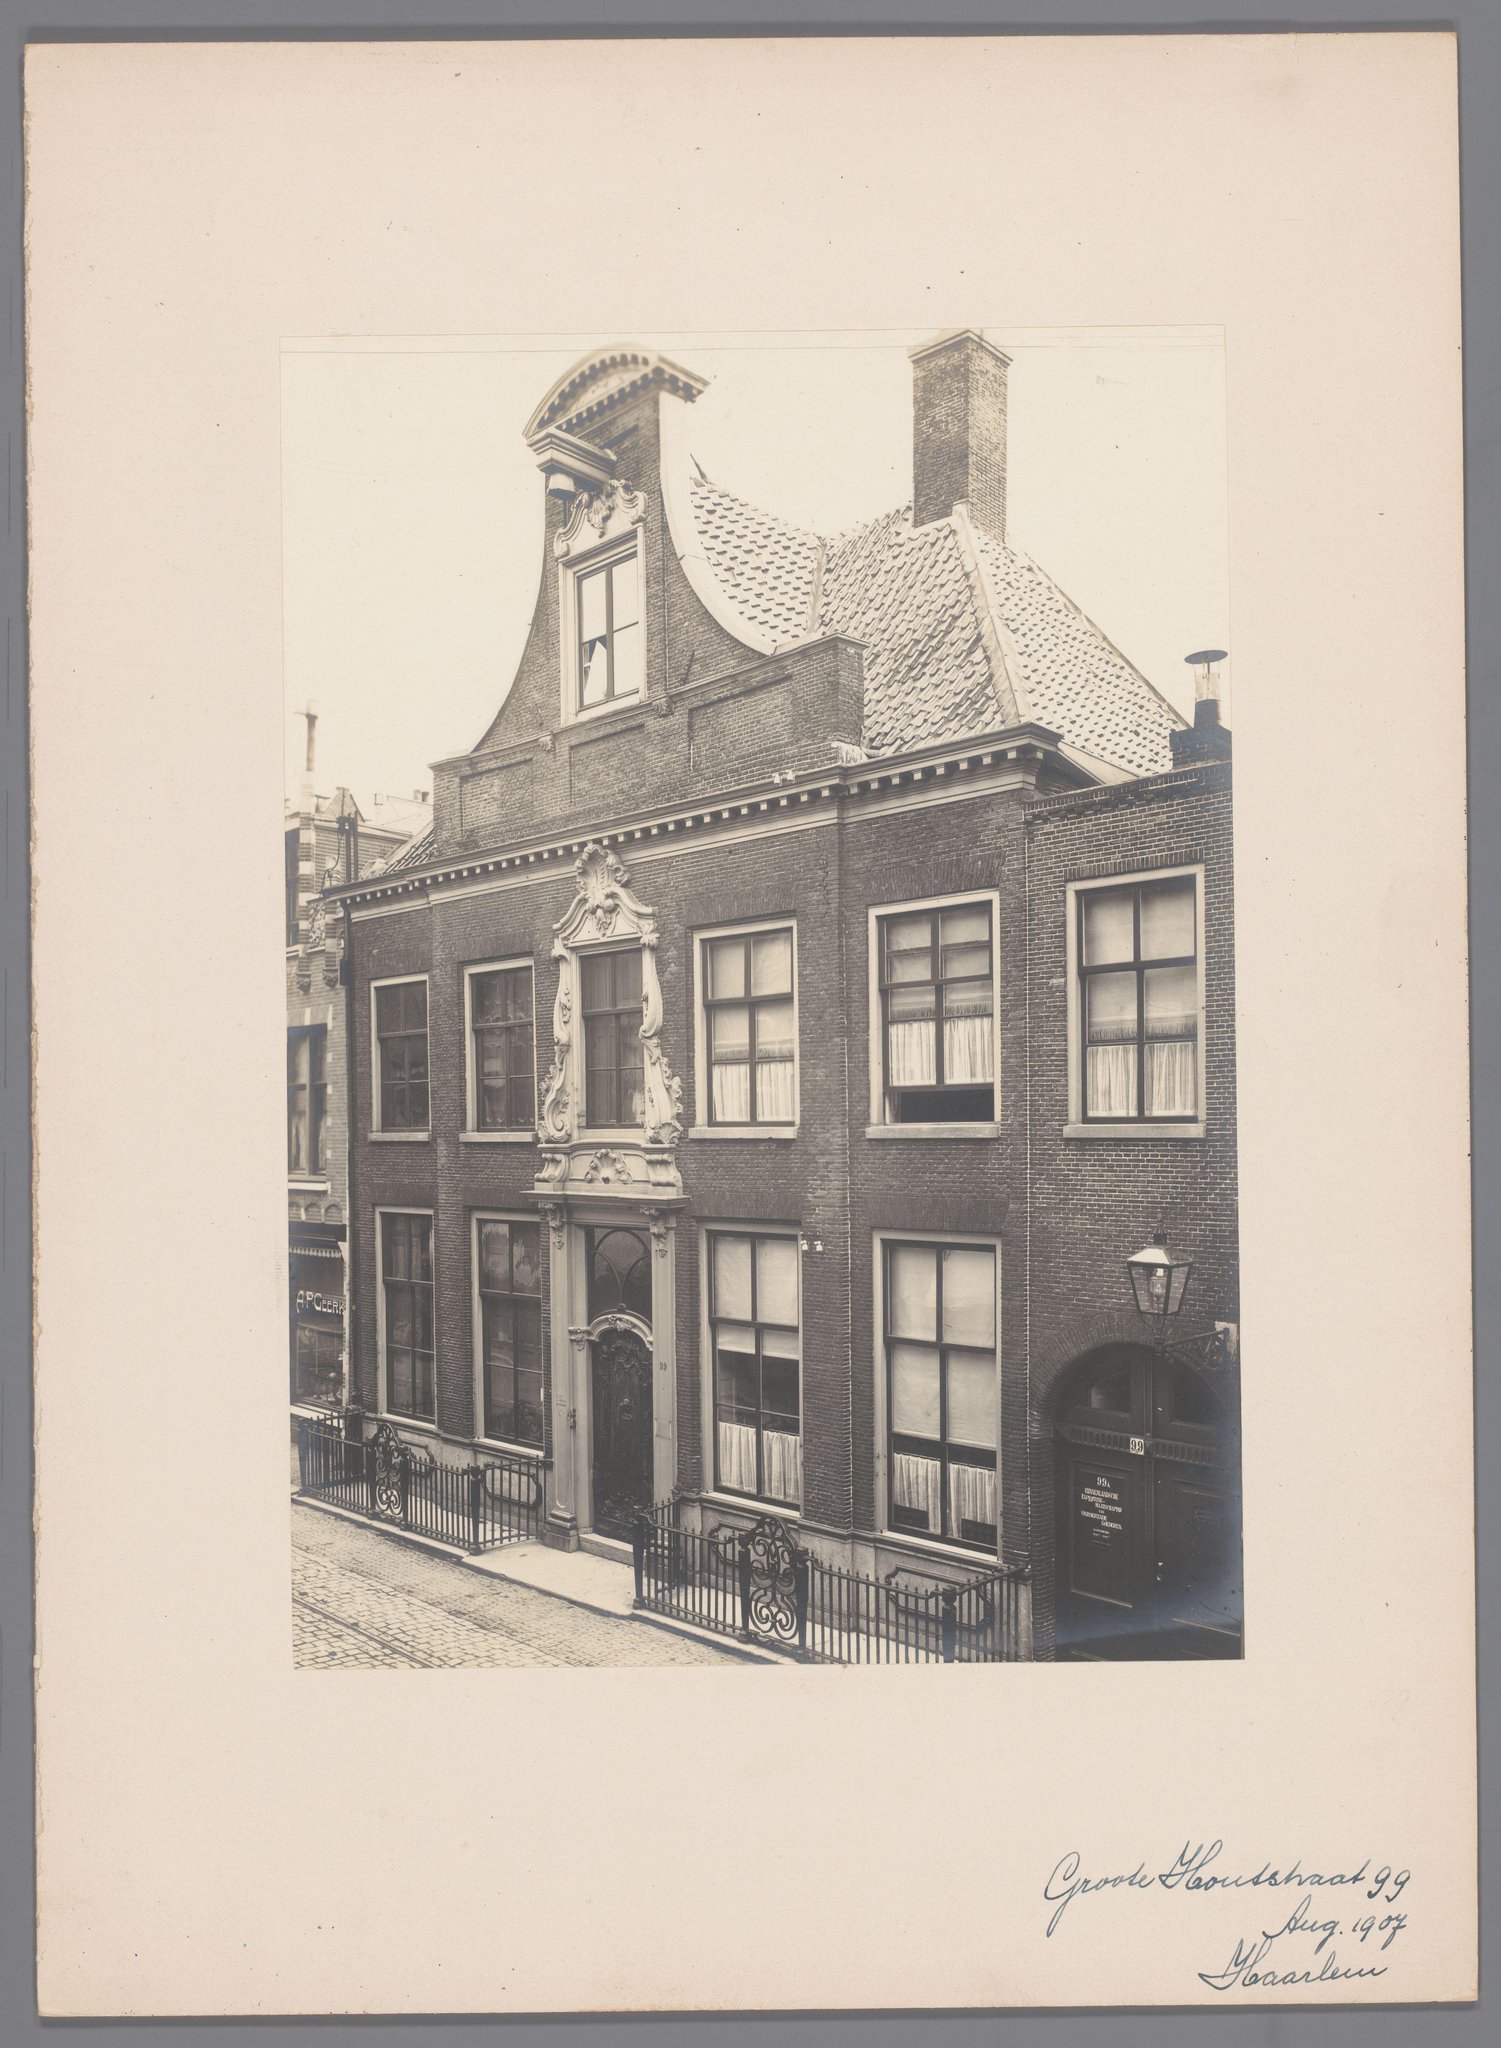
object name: photograph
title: Façade van Grote Houtstraat 99 te Haarlem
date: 1907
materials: cardboard, photographic support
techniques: gelatin silver print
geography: grote houtstraat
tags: urban housing, façade (of house or building)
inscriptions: annotation: ‘Groote Houtstraat 99/ Aug 1907/ Haarlem’, annotation: ‘Haarlem/ Groote Houtstraat 99/ Aug. 1907’